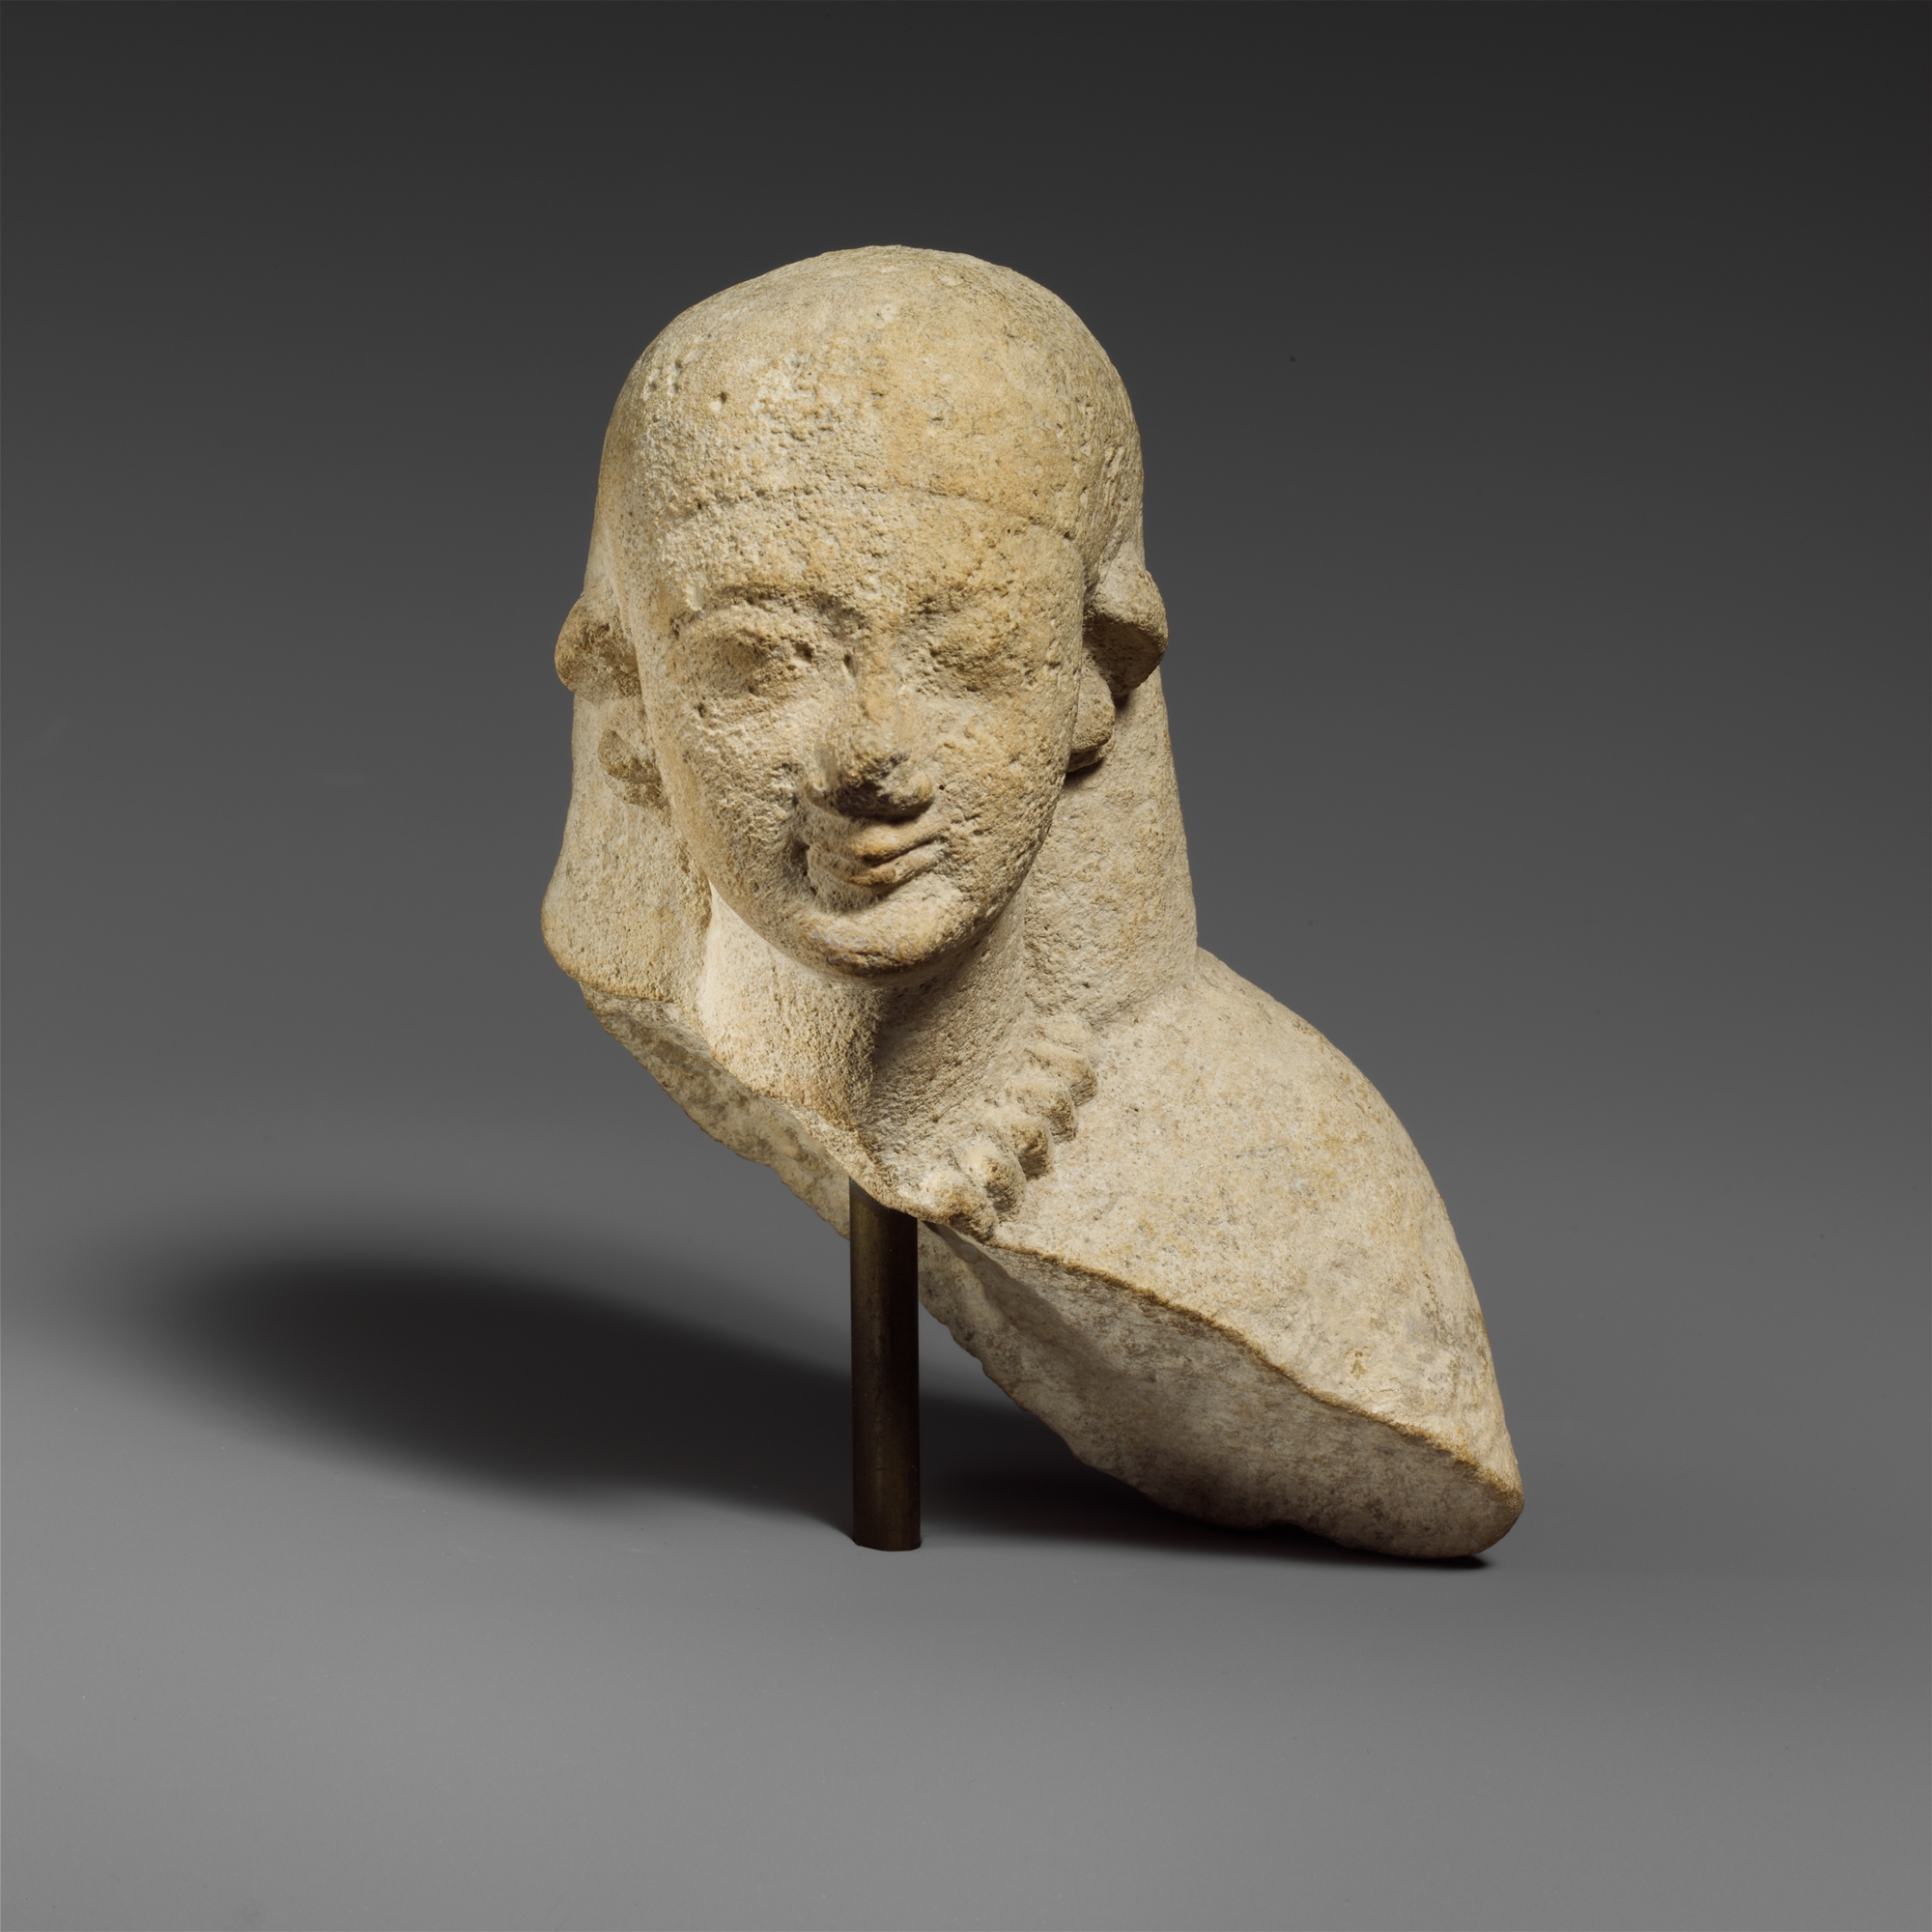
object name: head of a youth with egyptian headdress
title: Upper part of a female limestone votary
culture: cypriot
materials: limestone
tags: necklaces,faces,heads,women